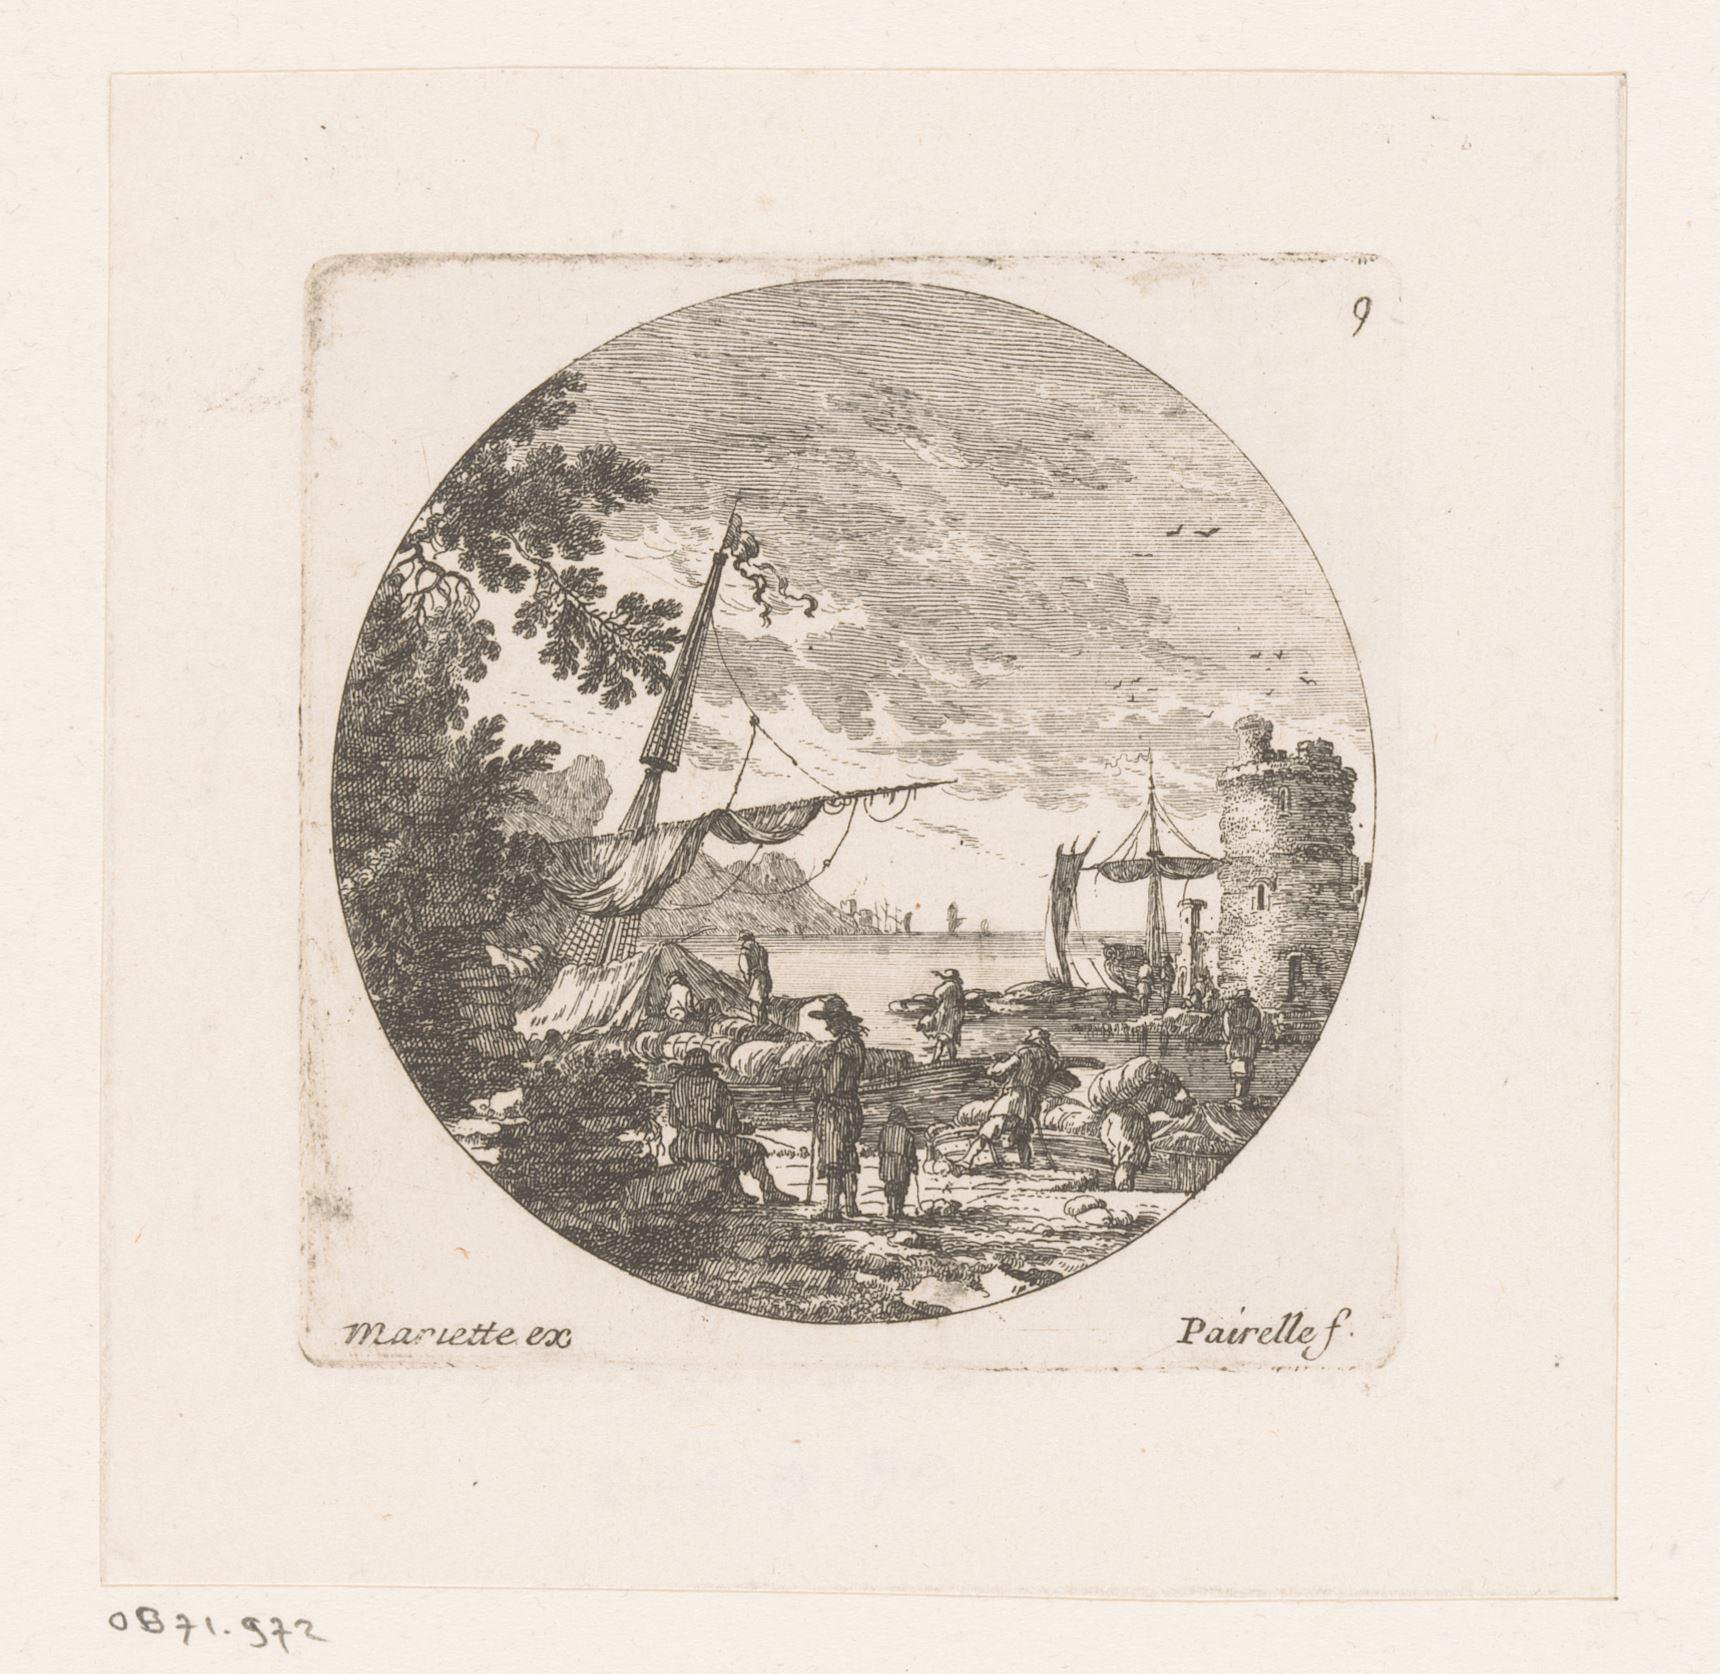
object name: print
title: Haven met toren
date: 1613-1695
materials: paper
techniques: etching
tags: harbour, towers ~ fortified city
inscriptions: collector's mark: Lugt 240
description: Prenten met het signatuur 'Perelle' kunnen zowel door vader Gabriel als door zonen Nicolas en Adam gemaakt zijn.